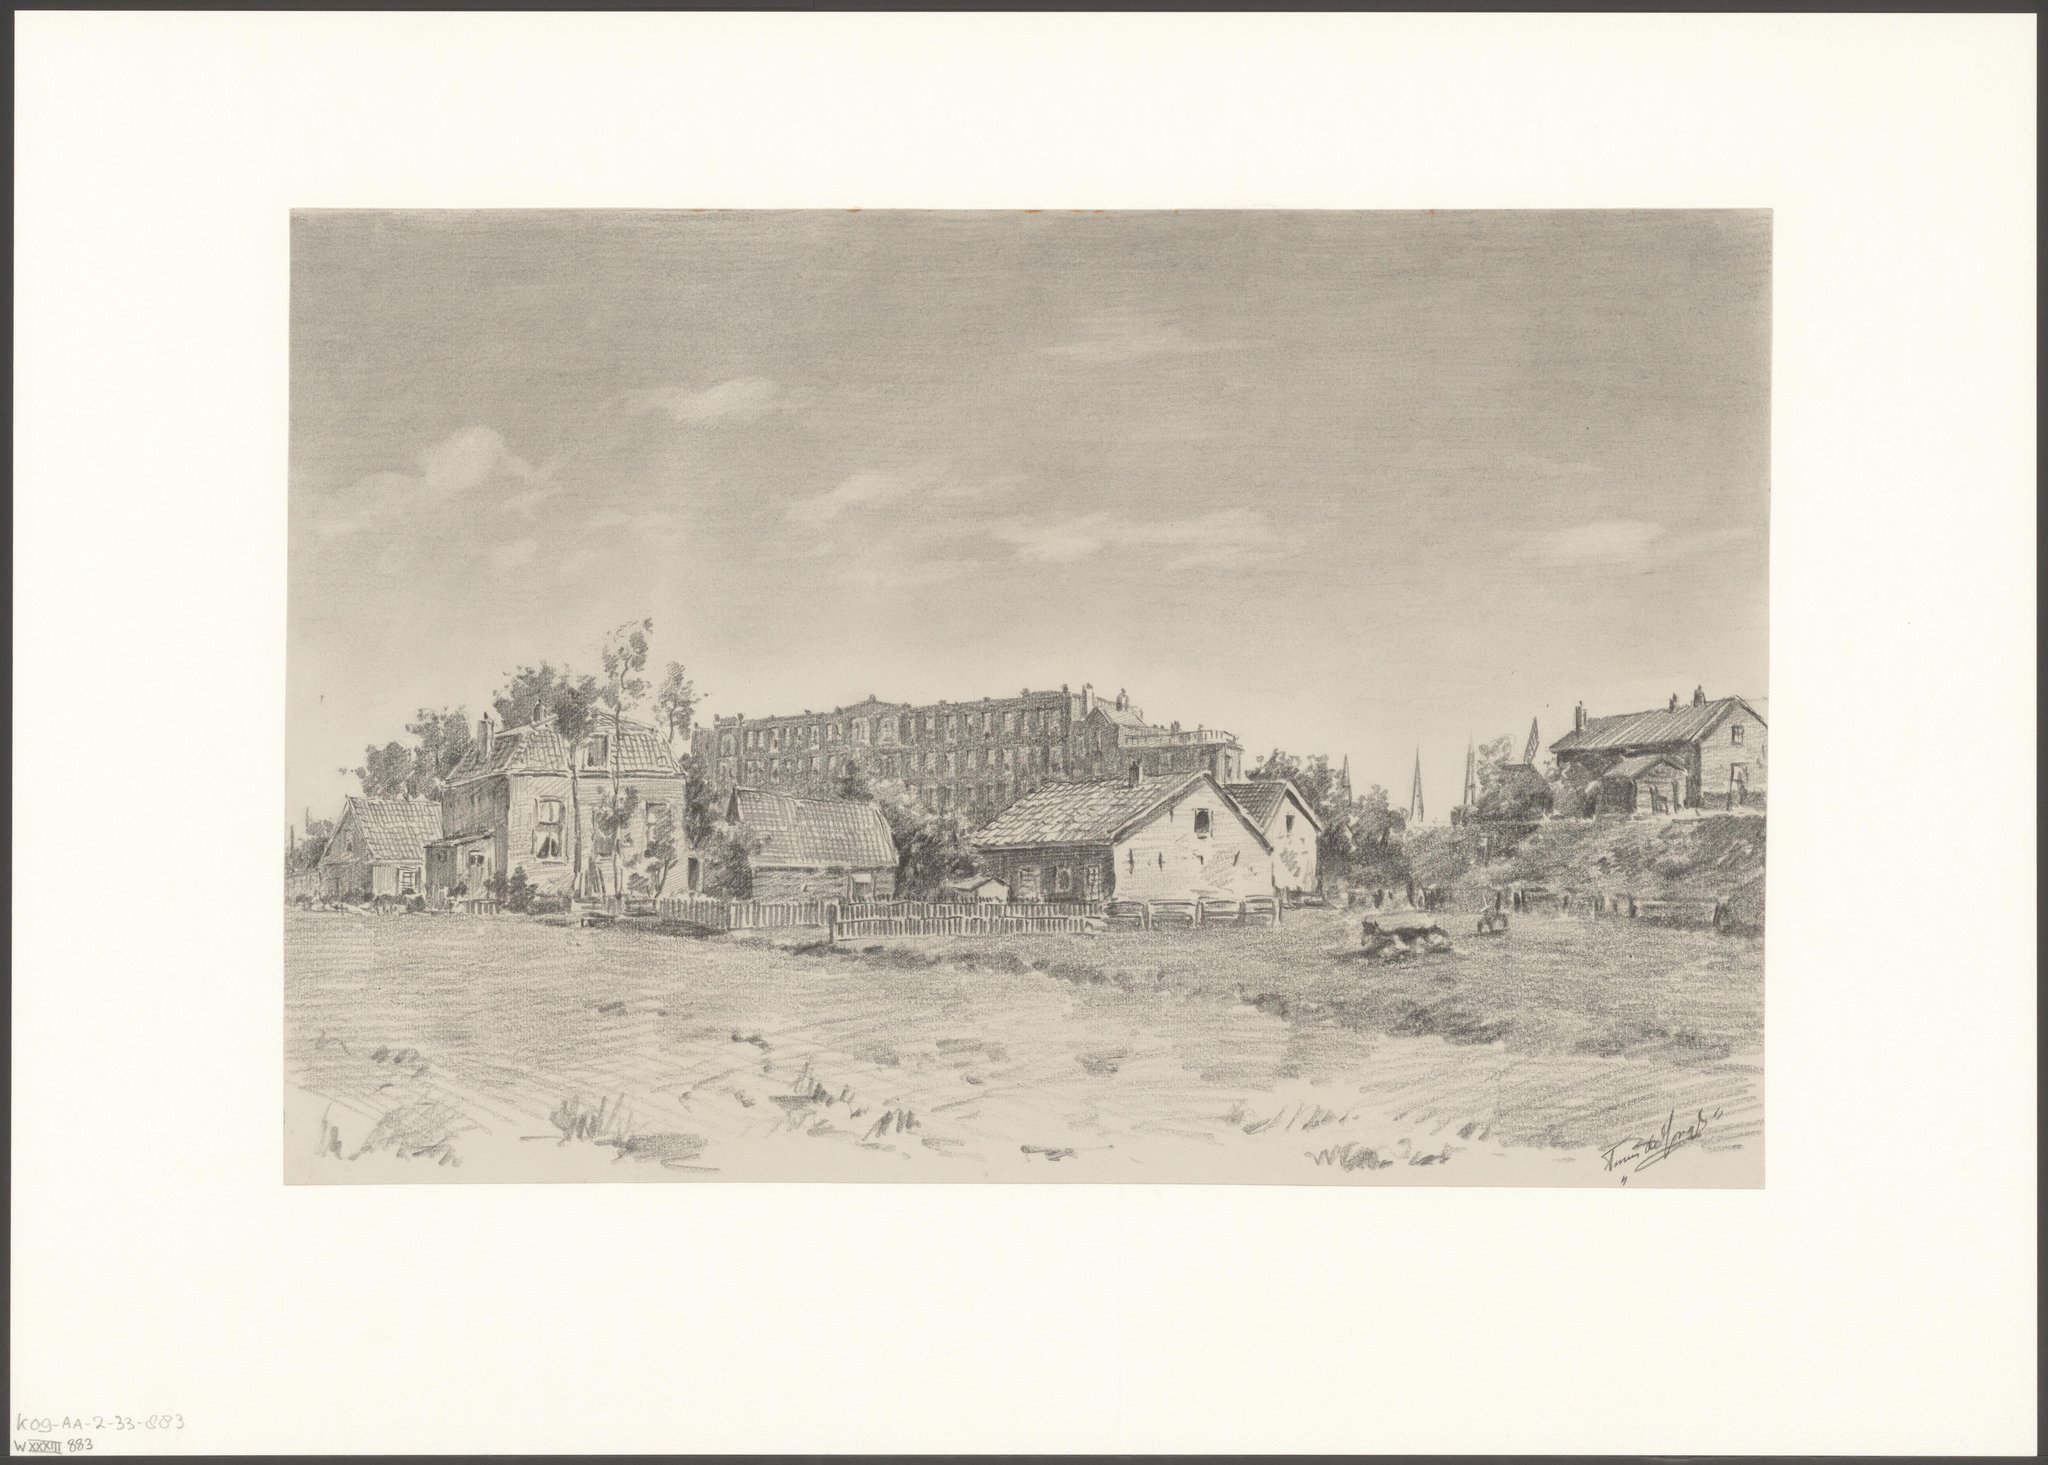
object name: drawing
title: Gezicht op de Weesperzijde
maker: tinus de jongh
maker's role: print maker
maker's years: 1885-1942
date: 1905-1919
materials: chalk, paper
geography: amsterdam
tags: city-view in general; 'veduta', road, path, the usual house or row of houses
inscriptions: signature and date: ‘Mei 1919. / "TinusdeJongh"’, signature: ‘"TinusdeJongh"’, collector's mark: Lugt 800a, inscription: ‘panorama van het (...) van de spoorbaan’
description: Tekening binnen de Atlas Van Eck ingedeeld op wijknummer 33.